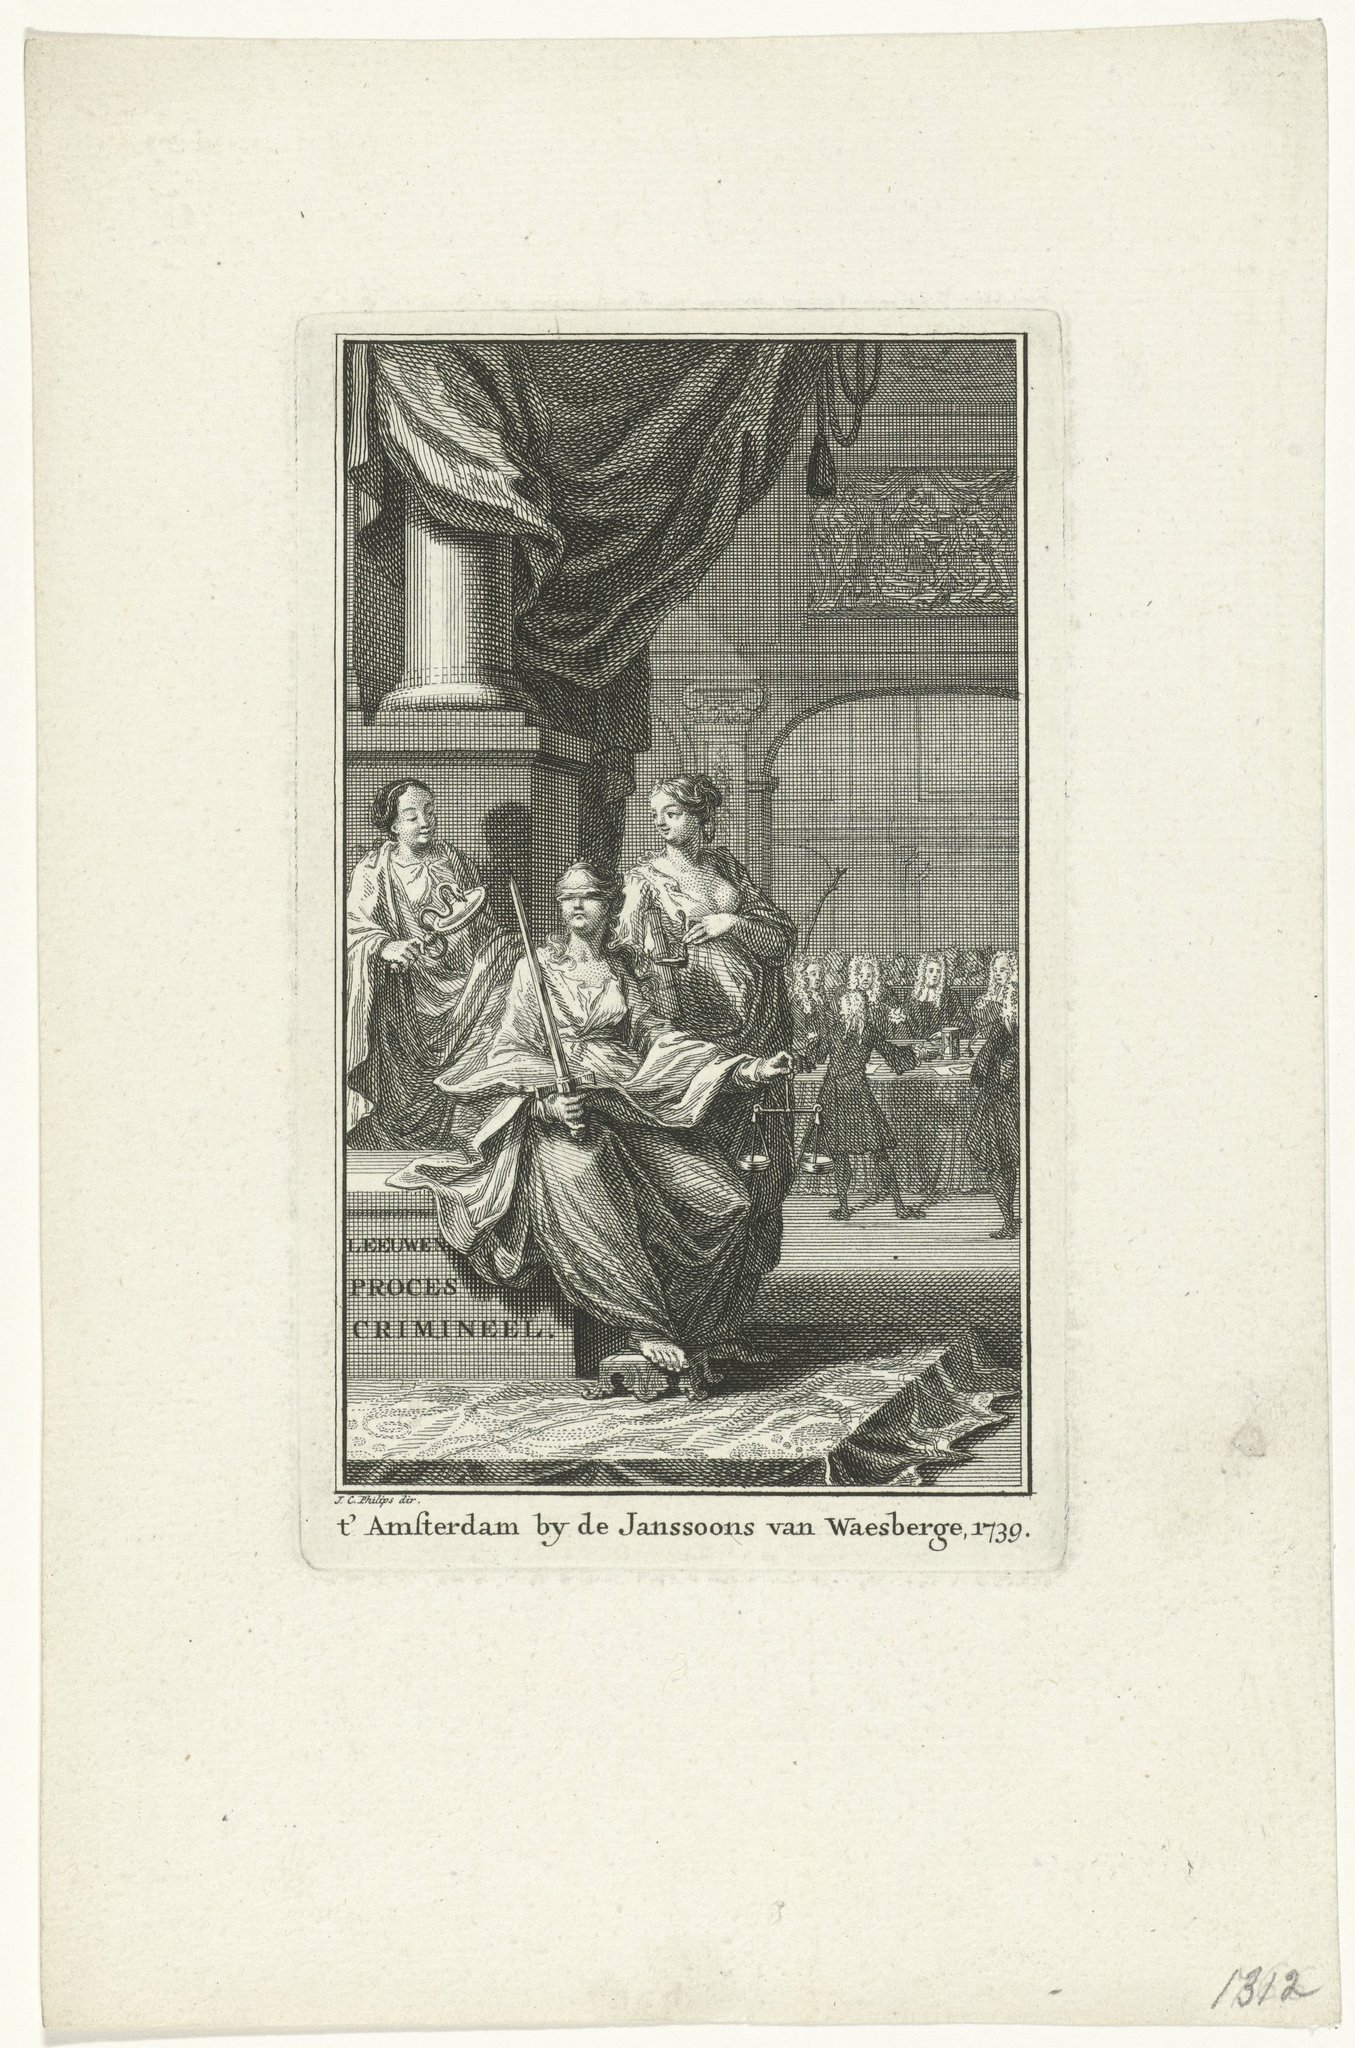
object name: print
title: Titelpagina voor: S. van Leeuwen, Proces crimineel, 1739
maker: jan caspar philips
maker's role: draughtsman, print maker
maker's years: 1700-1775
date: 1739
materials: paper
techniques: engraving, etching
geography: amsterdam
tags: justitia (justice) as roman personification, alertness, vigilance; 'guardia', 'vigilanza', 'vigilanza per difendersi & oppugnare altri' (ripa), court-room, prudentia (prudence) as roman personification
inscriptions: collector's mark: Lugt 2228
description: Rechtvaardigheid (Justitia) vergezeld door Voorzichtigheid (Prudentia) en Waakzaamheid (Vigilantia), met een olielamp in haar hand. Op de achtergrond de rechtszaal met rechters. Op de verhoging links op de voorgrond de titel in het Nederlands.